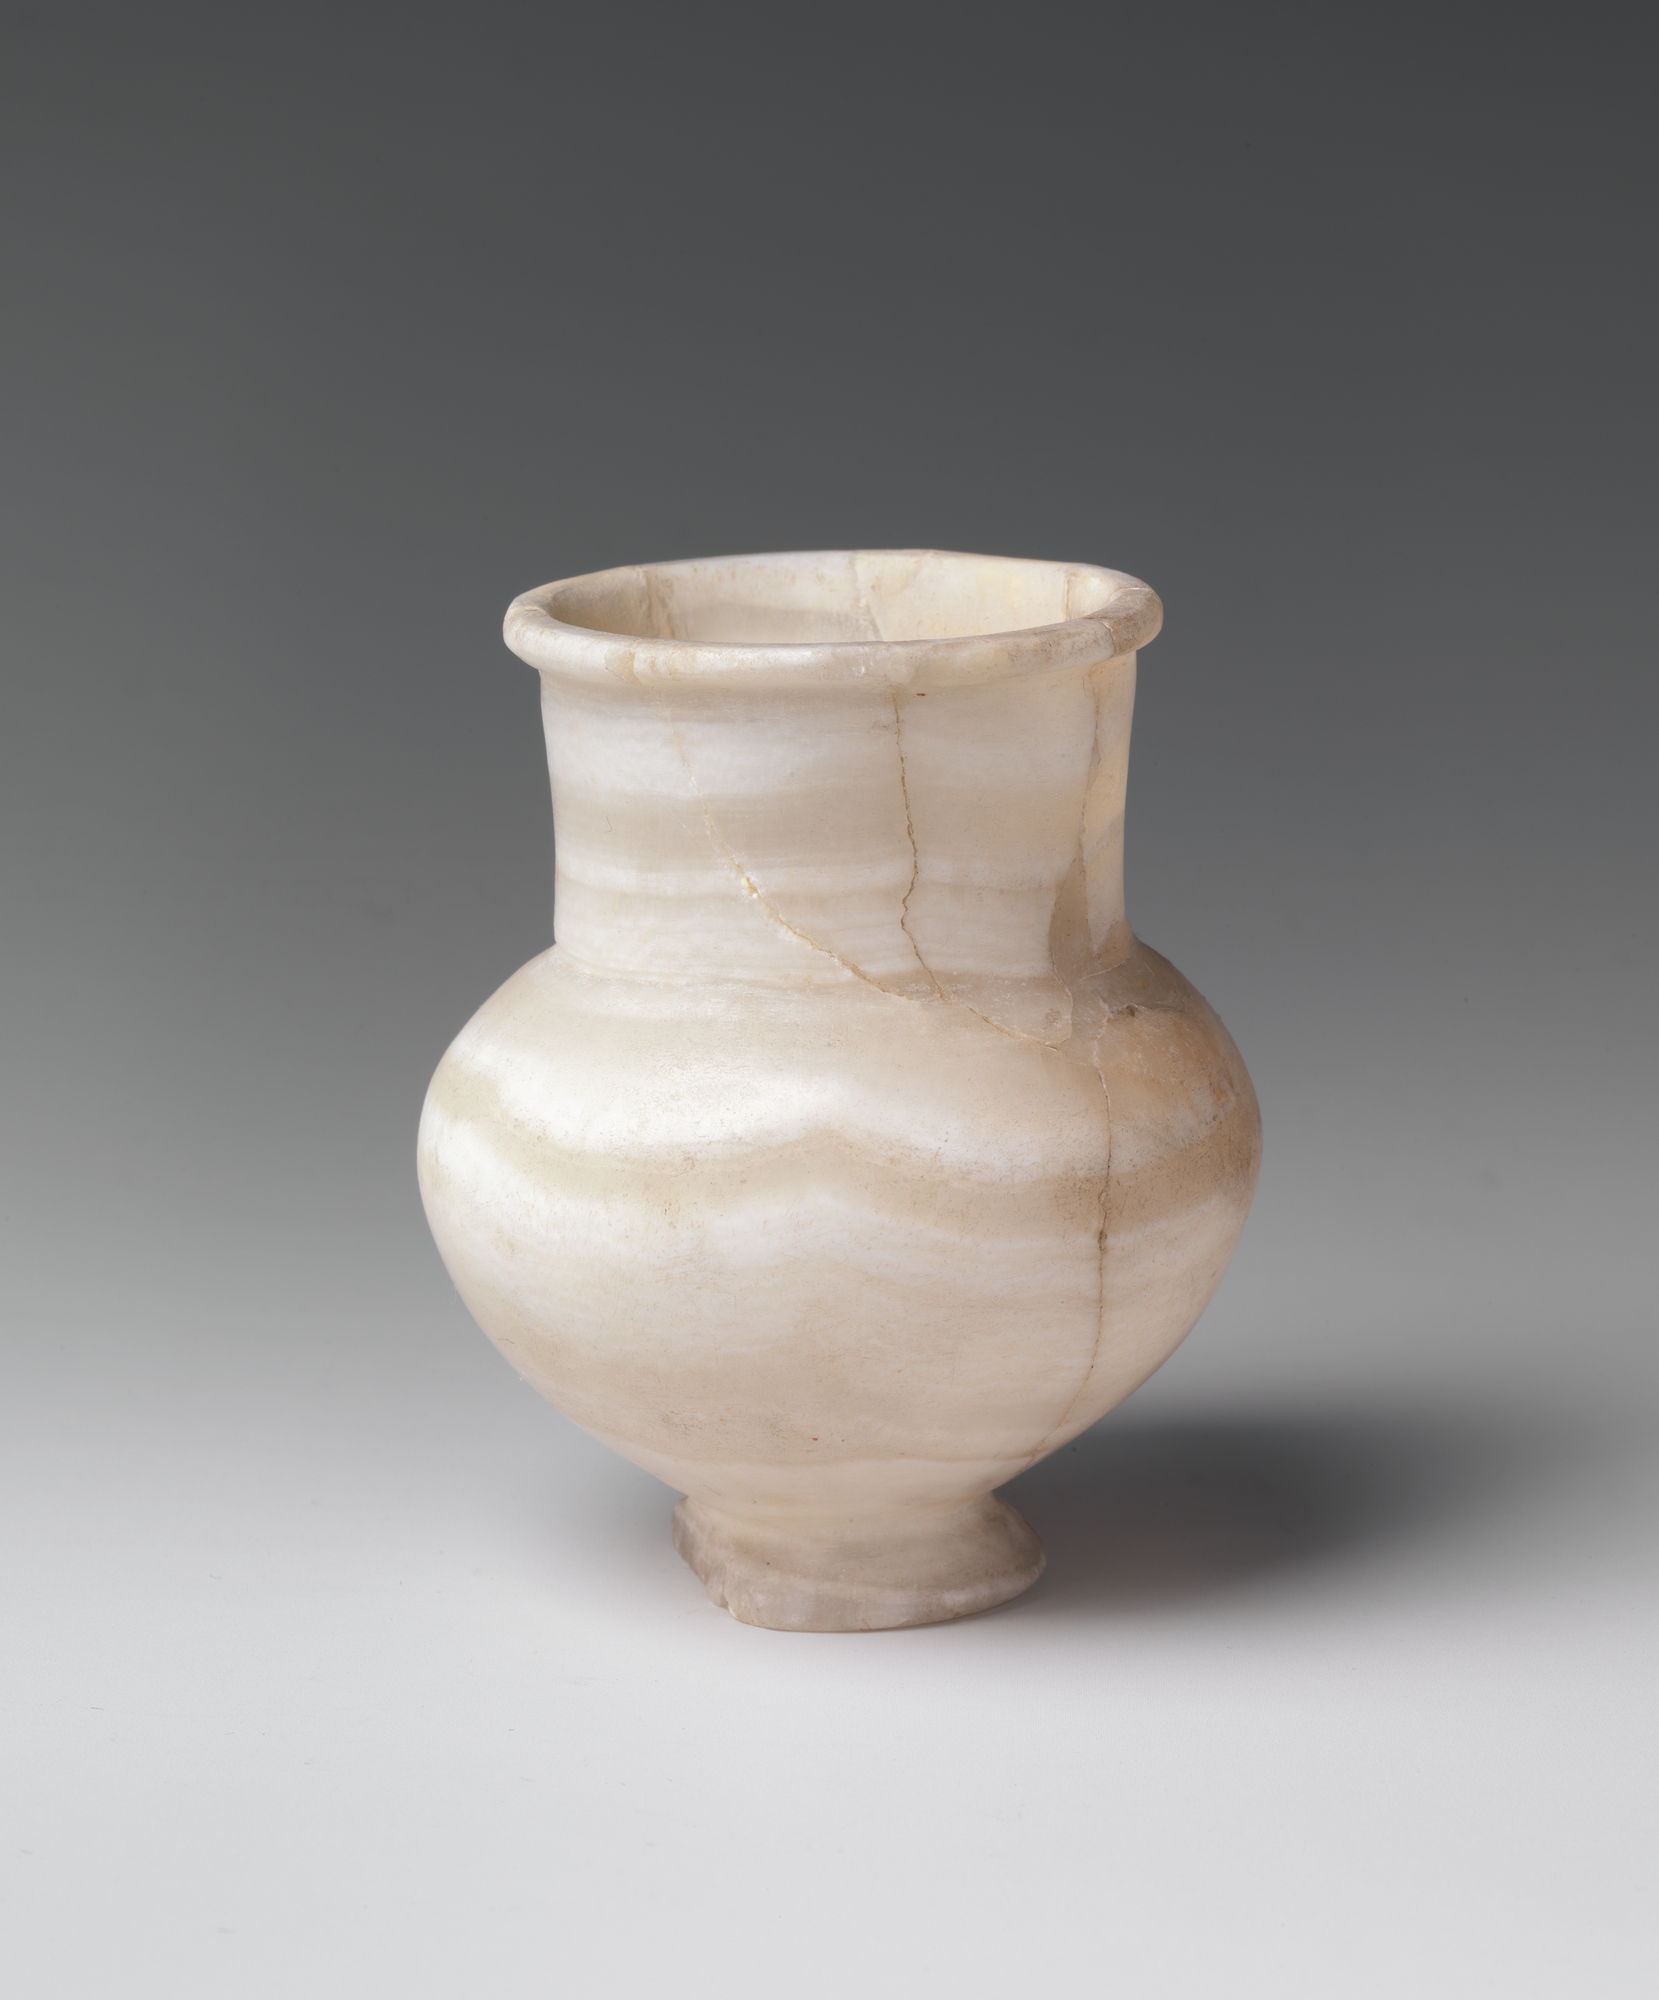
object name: jar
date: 1550-1458 BCE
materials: stone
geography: egypt